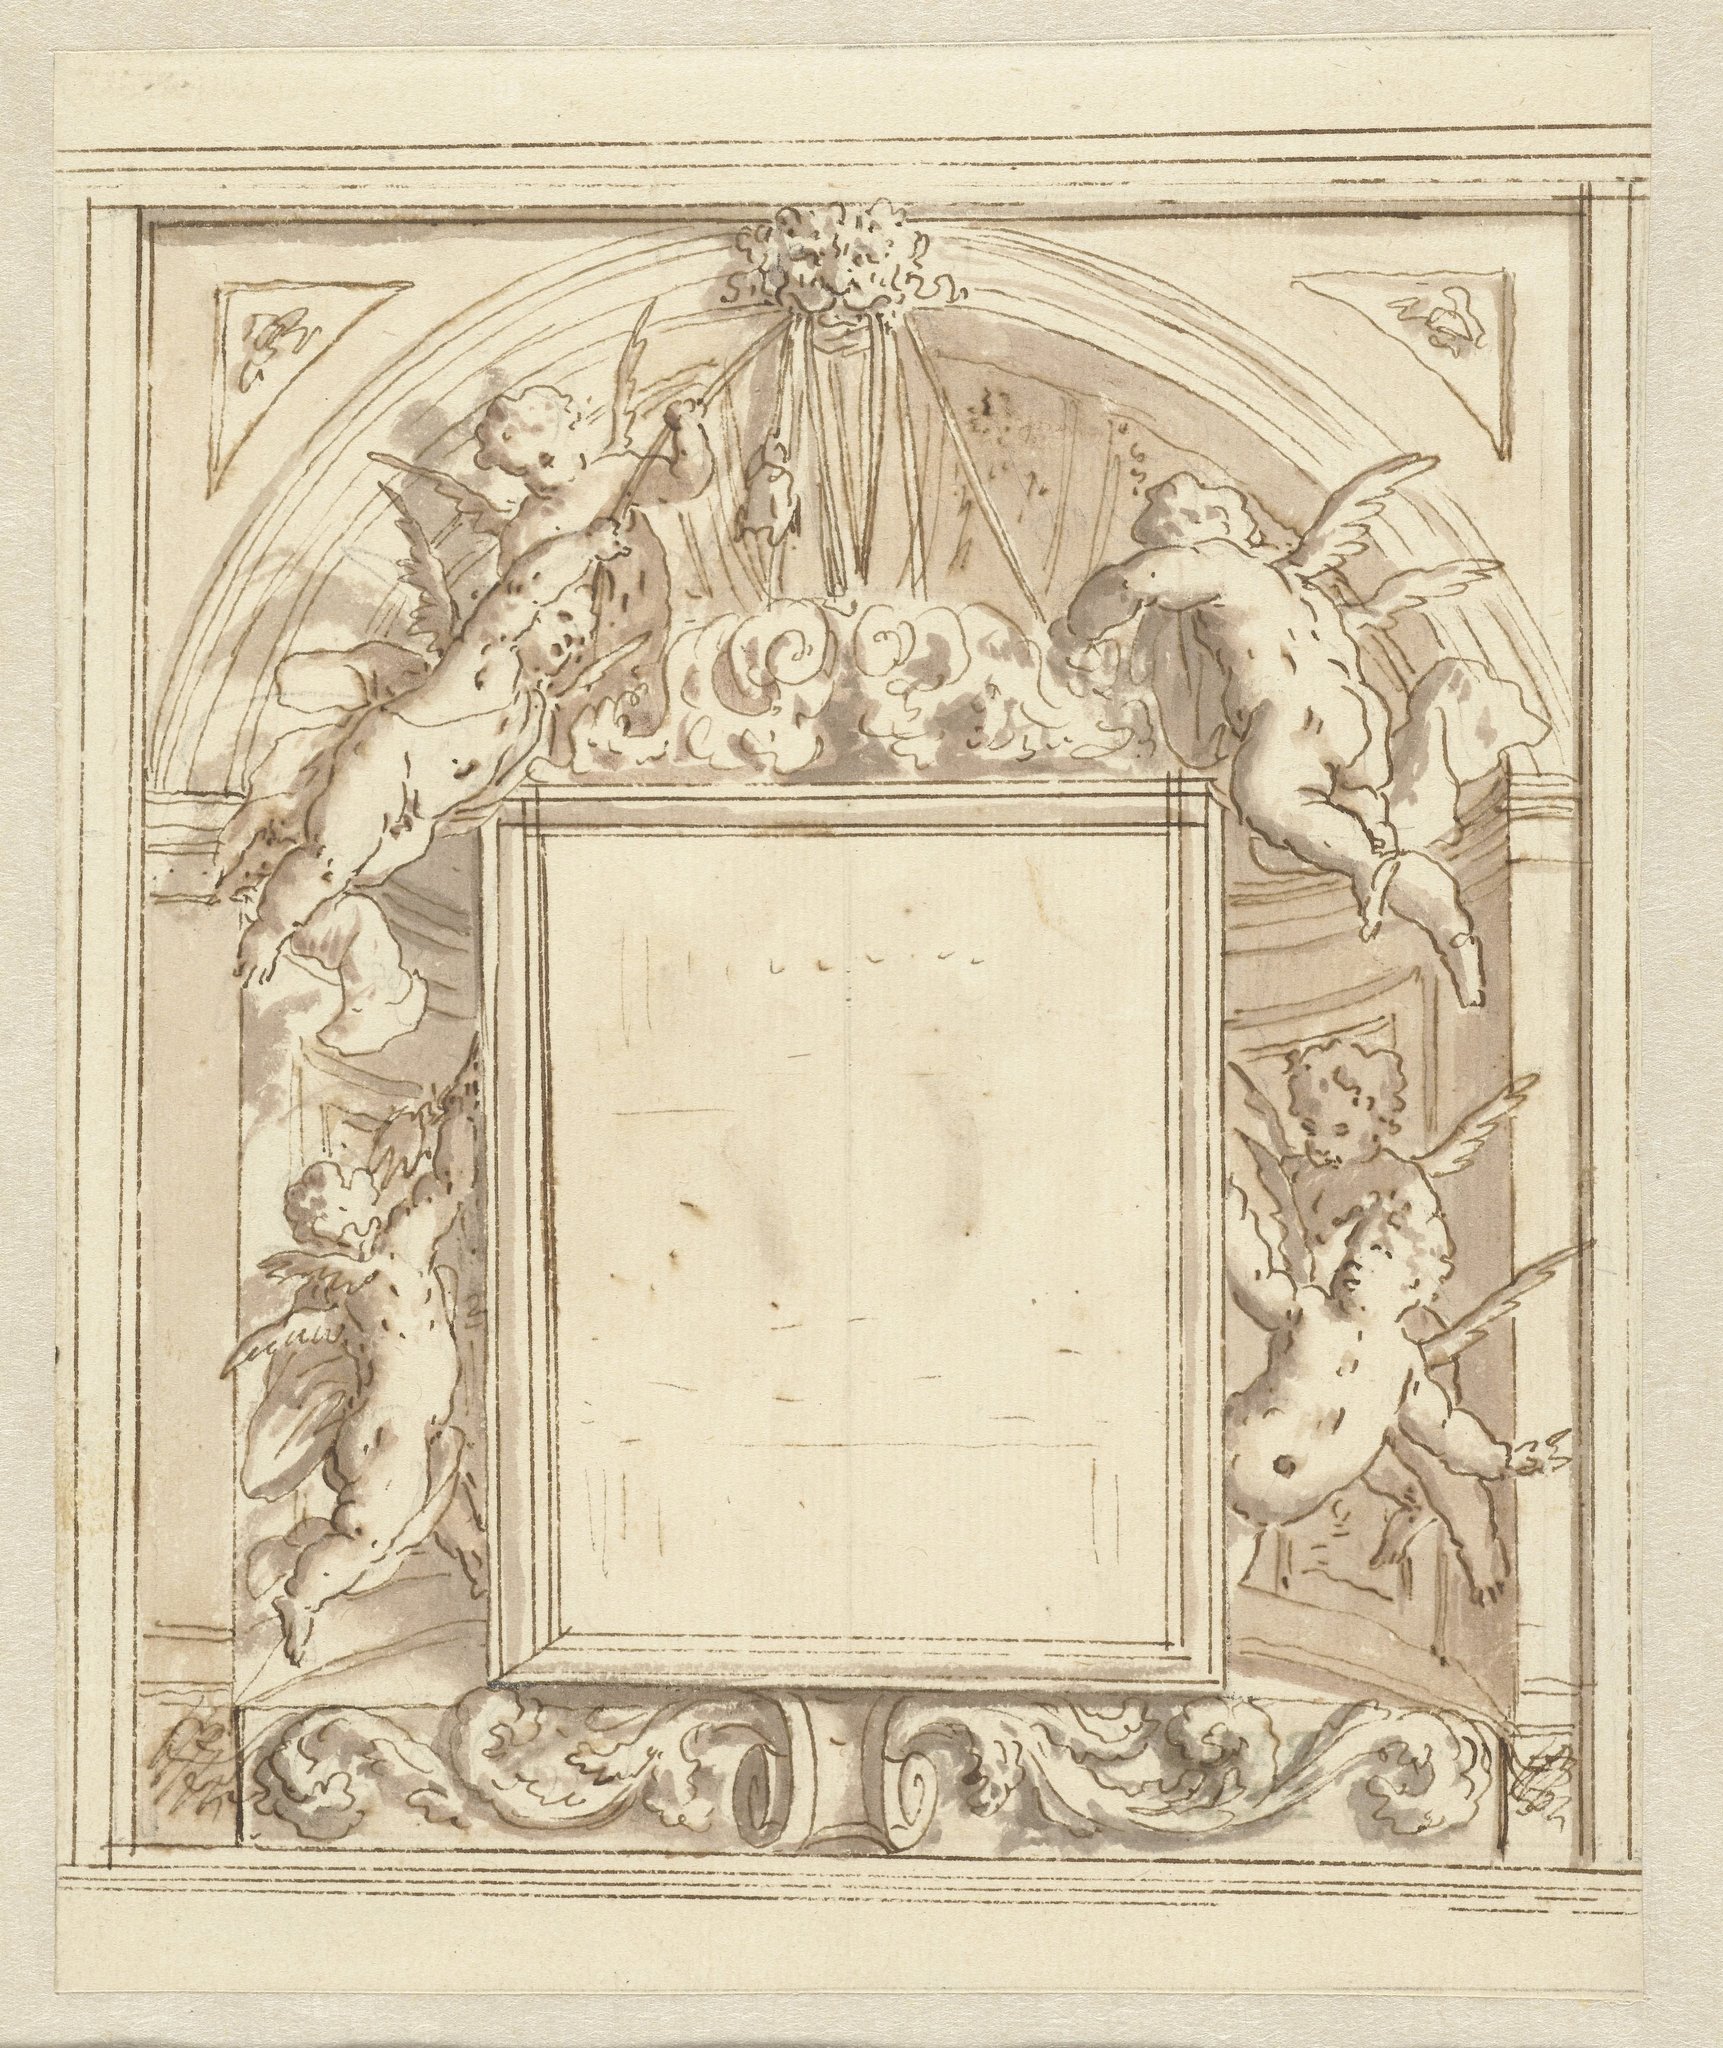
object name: drawing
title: Cartouche omringd door putti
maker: mattheus terwesten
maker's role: draughtsman, painter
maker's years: 1670-1757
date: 1600-1604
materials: graphite, ink, paper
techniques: brush, pen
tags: ornament ~ cartouche, cupids: 'amores', 'amoretti', 'putti'